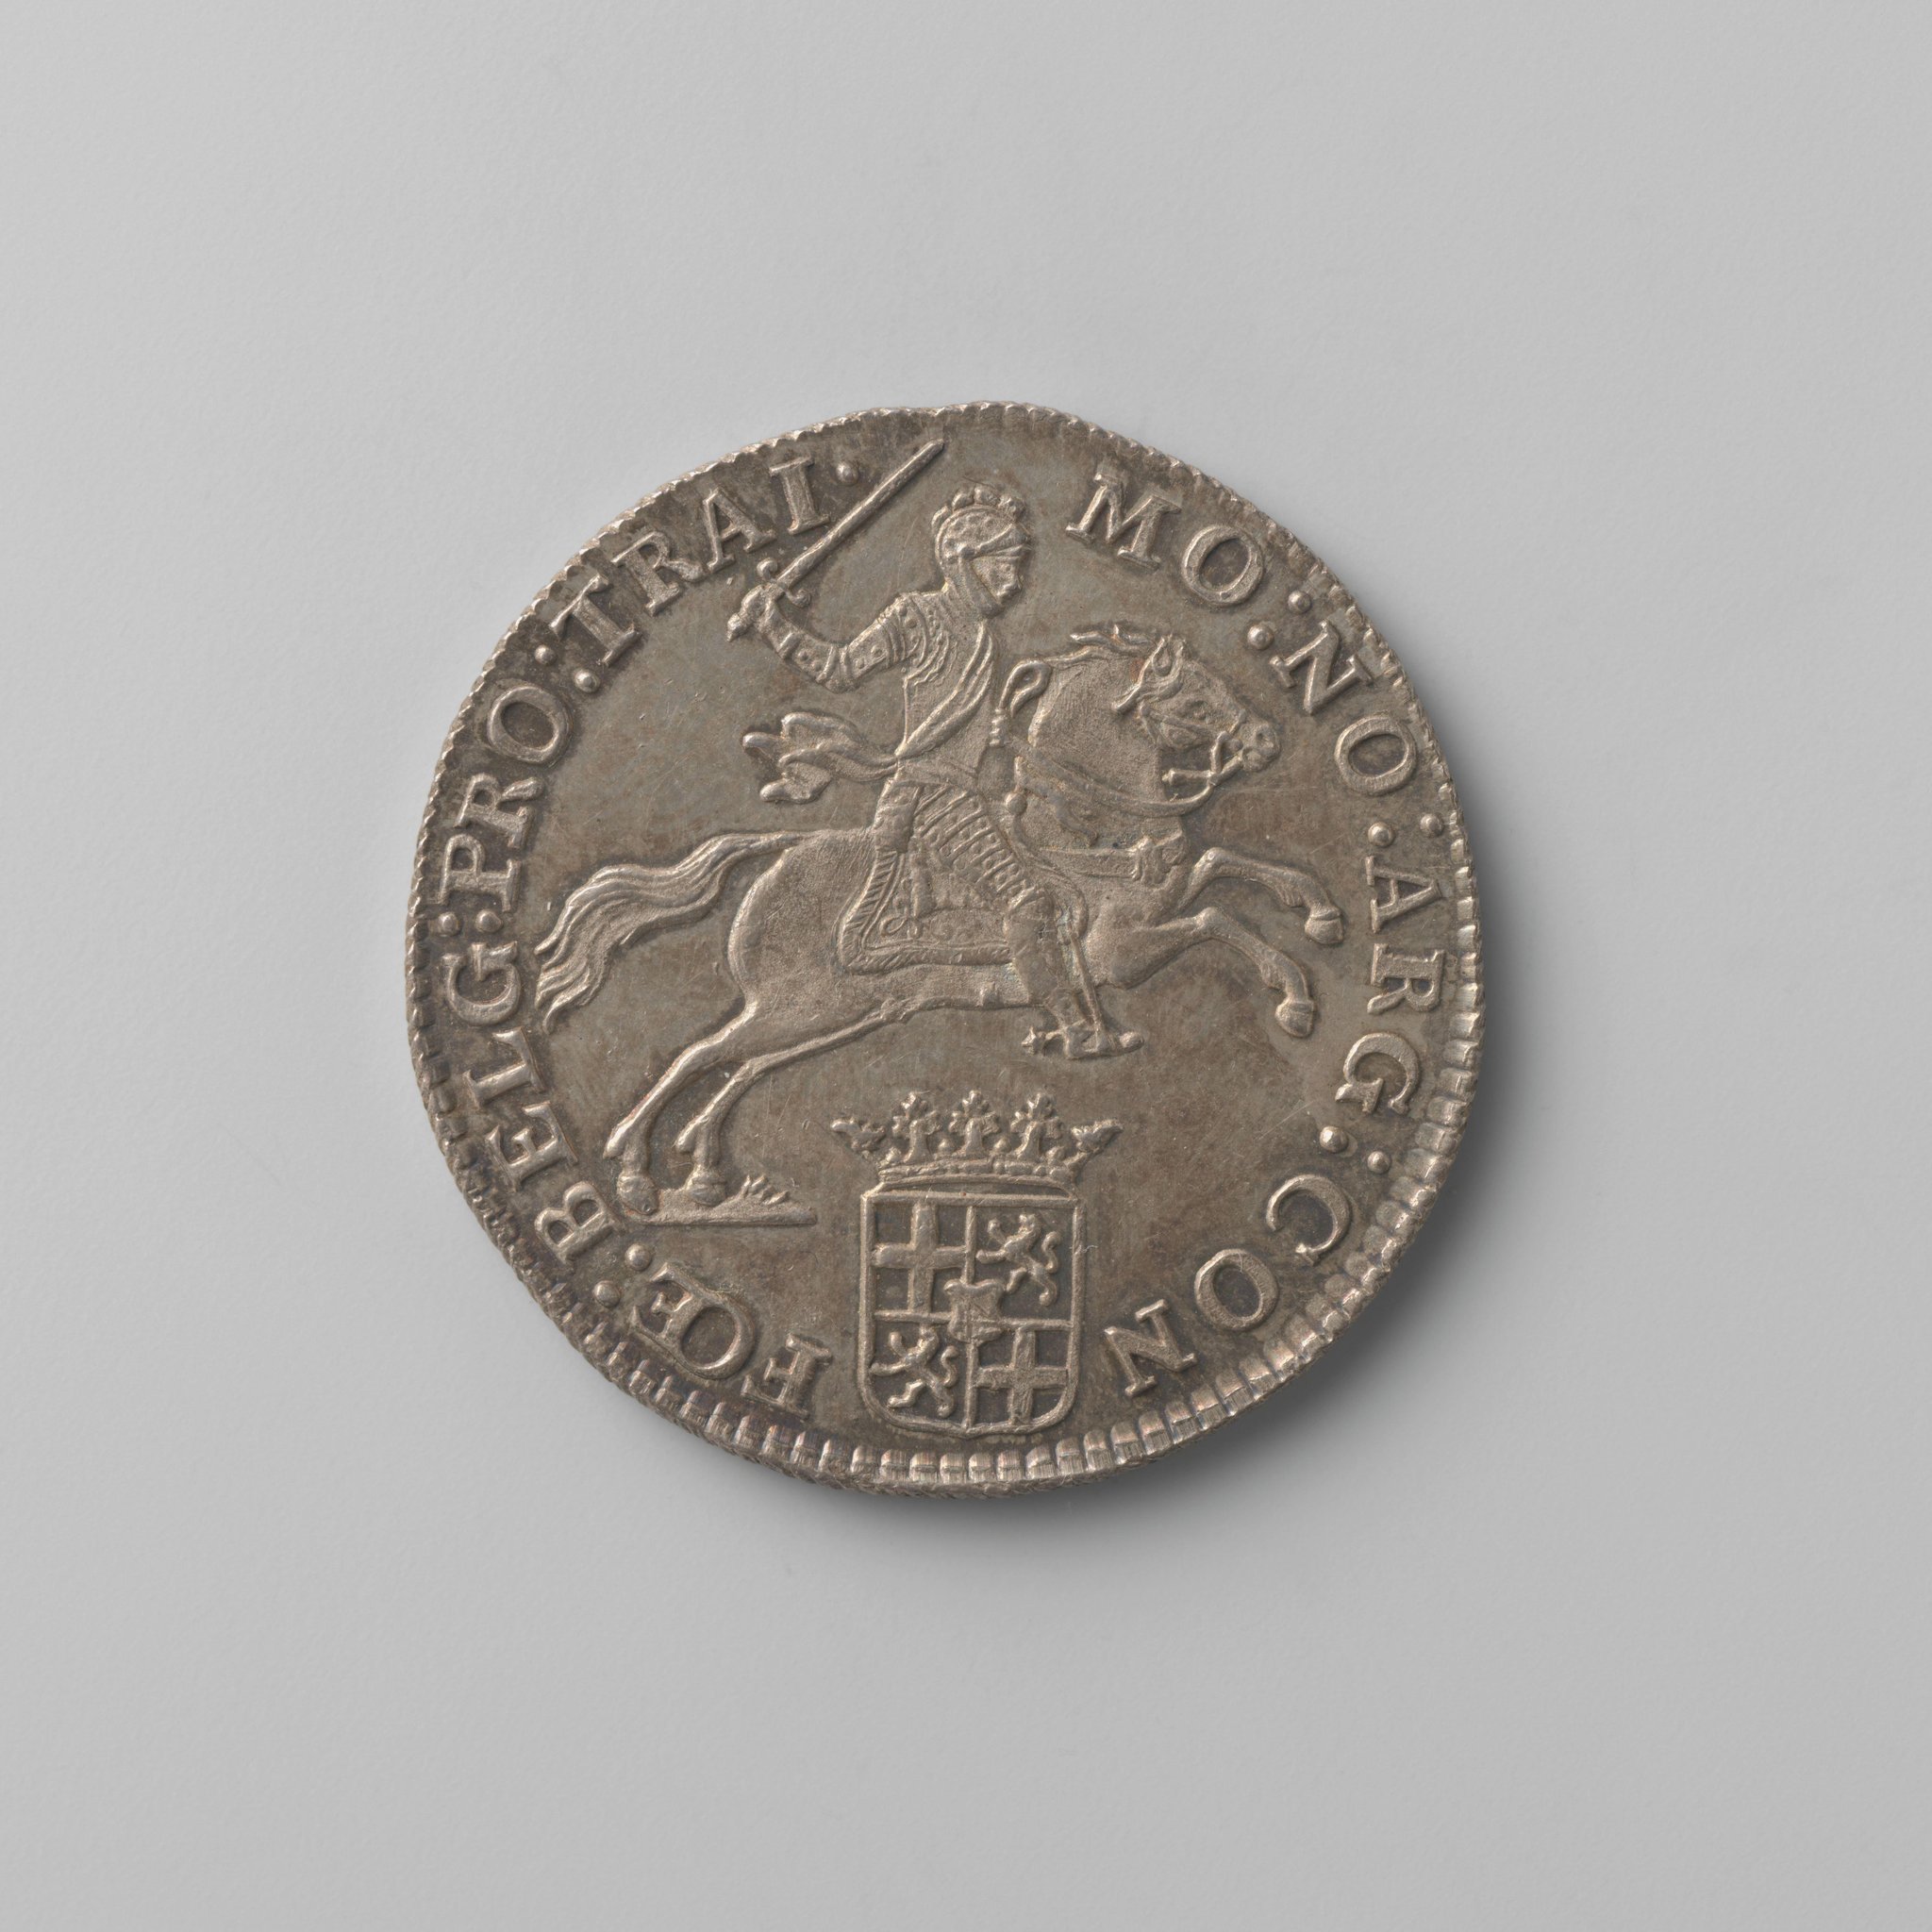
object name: coin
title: Utrechtse halve zilveren rijder, 1785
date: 1785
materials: silver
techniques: striking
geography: utrecht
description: Zilveren munt. Voorzijde: ridder te paard naar rechts met in rechterhand zwaard. Onder paard gekroond wapenschild van Utrecht. Keerzijde: door twee gekroonde leeuwen gehouden generaliteitswapenschild. Daaronder in cartouche jaartal. Kabelrand.